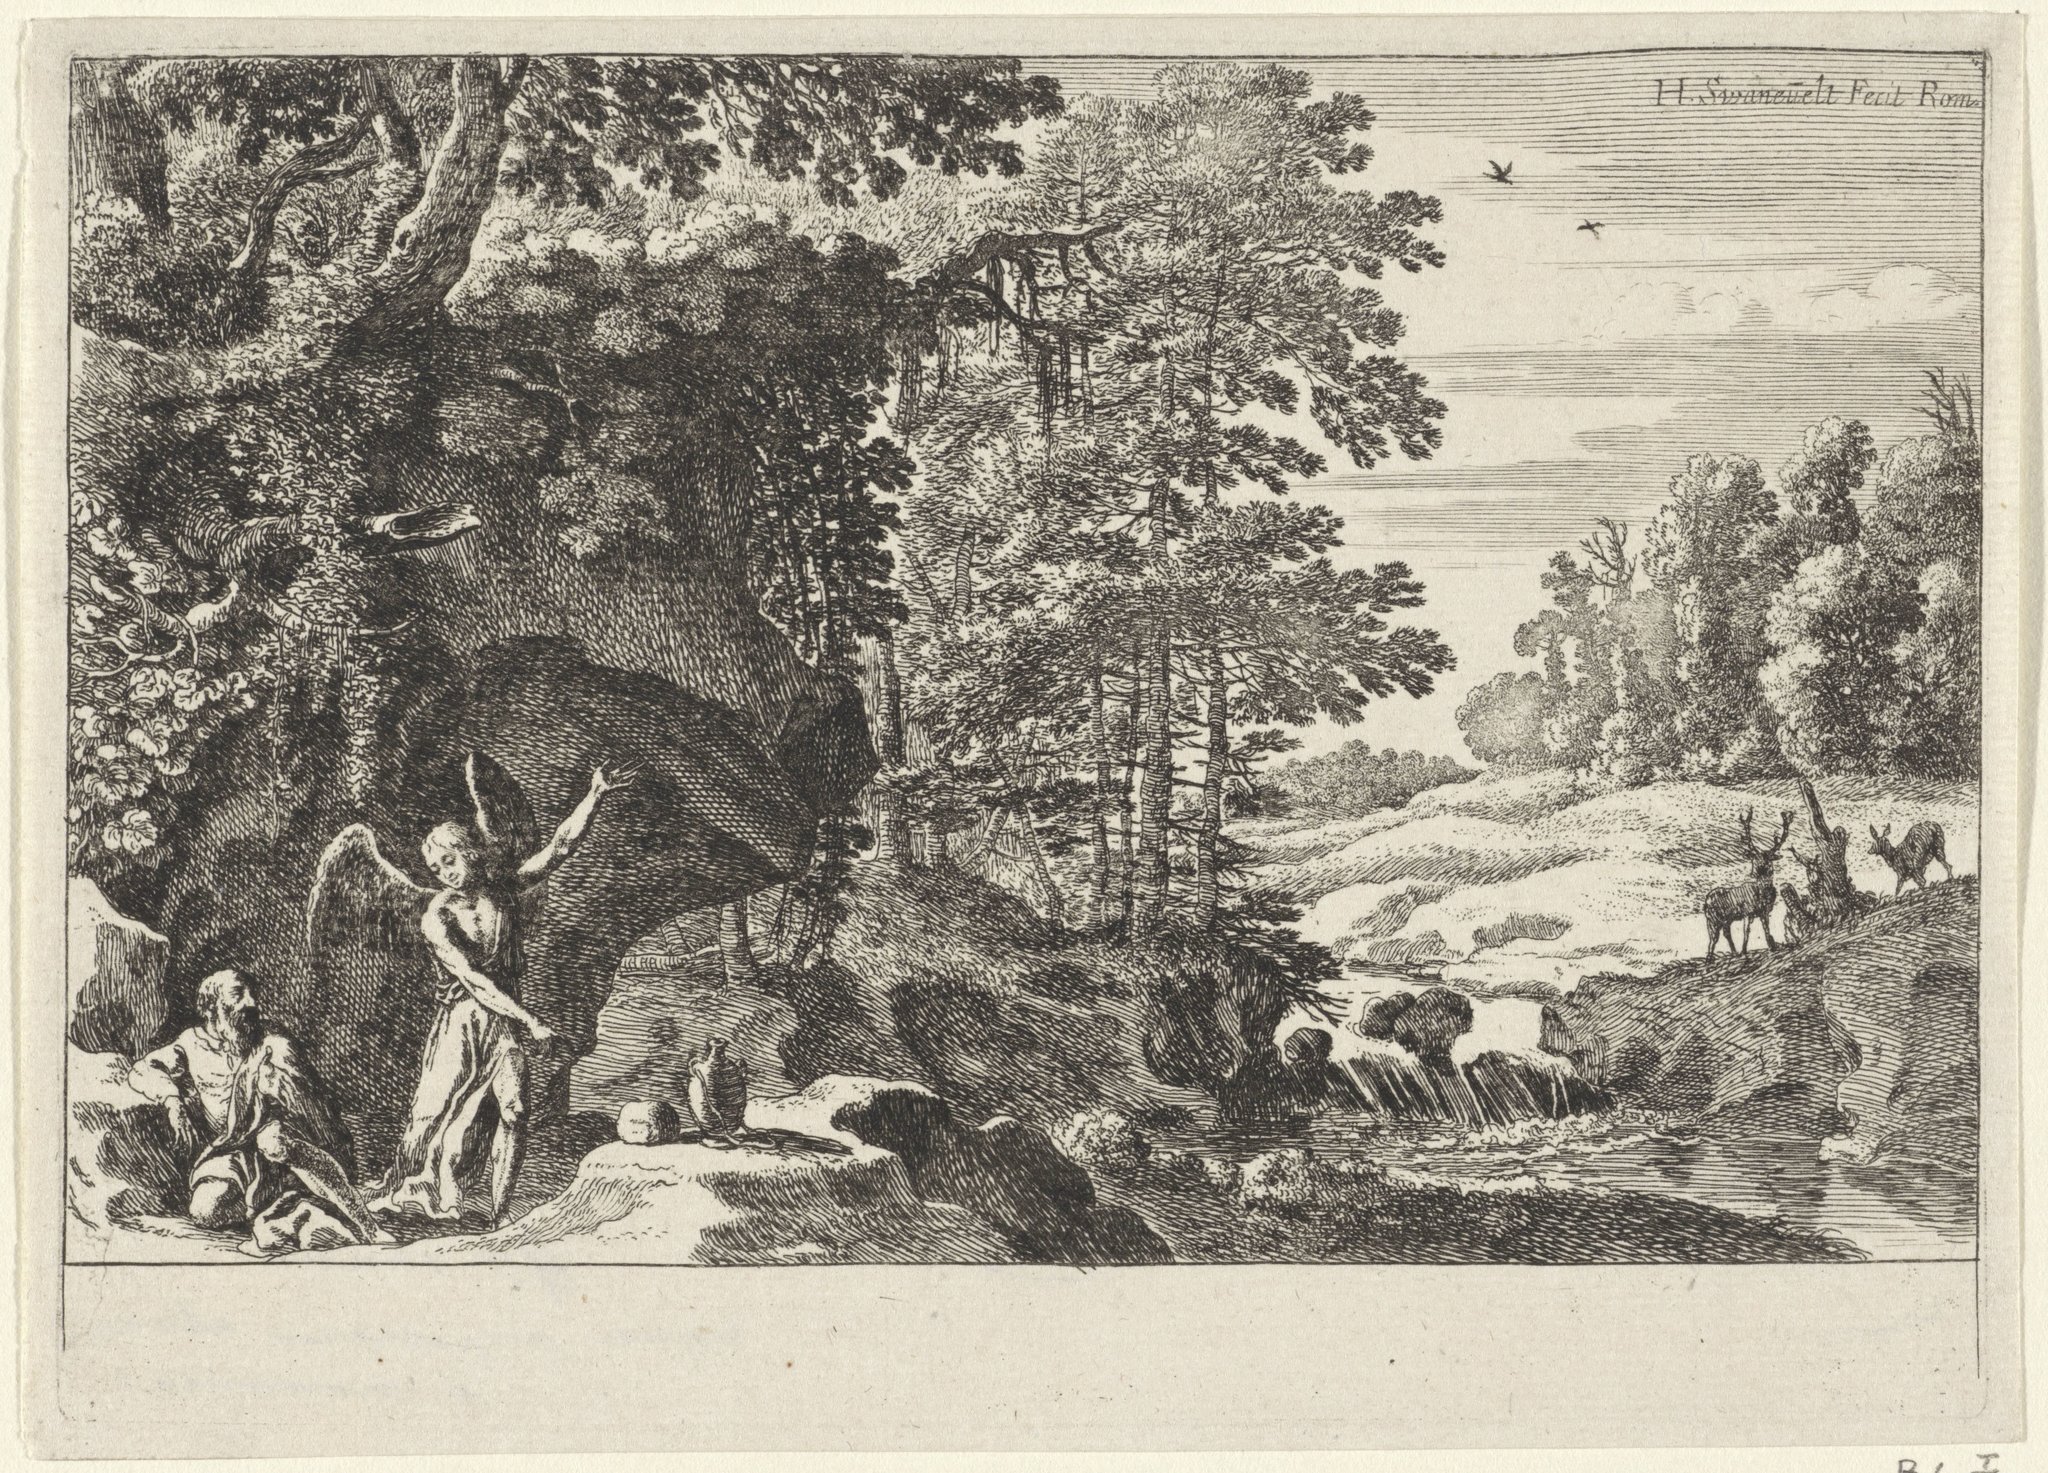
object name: print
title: Oudtestamentische voorstellingen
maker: herman van swanevelt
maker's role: draughtsman, painter, print maker, publisher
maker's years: 1603-1655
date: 1629-1641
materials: paper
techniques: etching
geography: rome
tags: an angel wakes elijah; a loaf of bread and a jar of water are usually at elijah's head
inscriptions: collector's mark: Lugt 2228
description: In een rotsachtig landschap met boompartijen en een waterpartij is links op de voorgrond een engel weergegeven die de geknielde Ellia wekt en hem op een stuk brood en een kruik met water wijst.